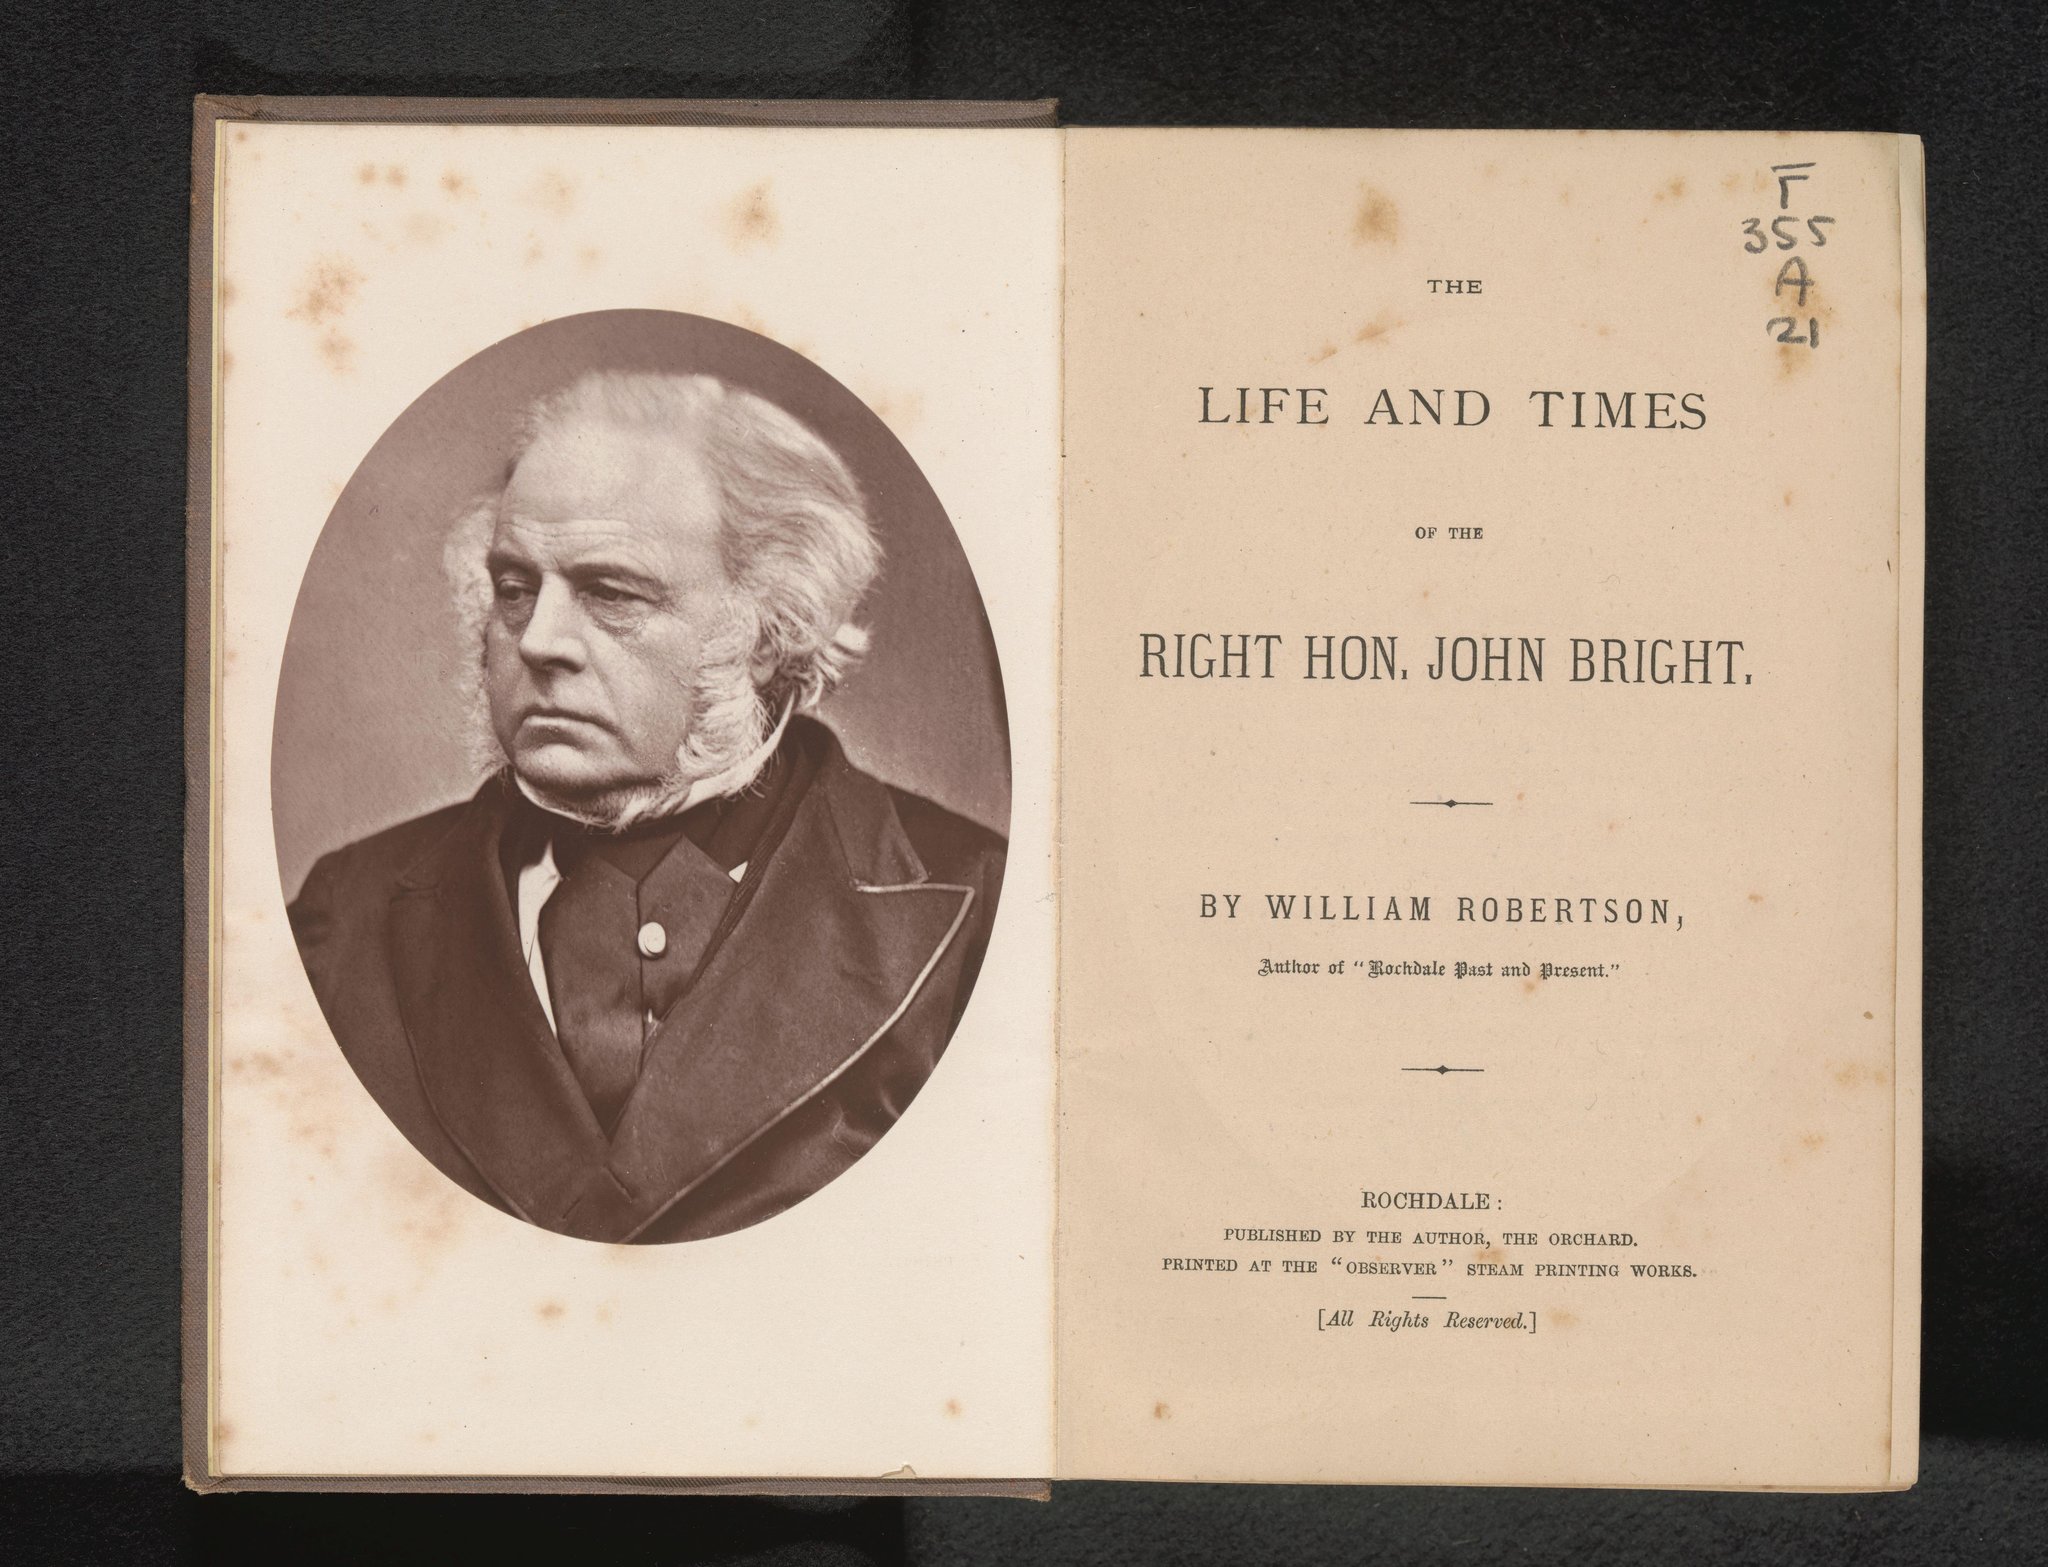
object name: page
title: Portret van John Bright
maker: Anonymous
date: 1873-1878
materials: paper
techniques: woodburytype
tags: politician, e.g. party leader